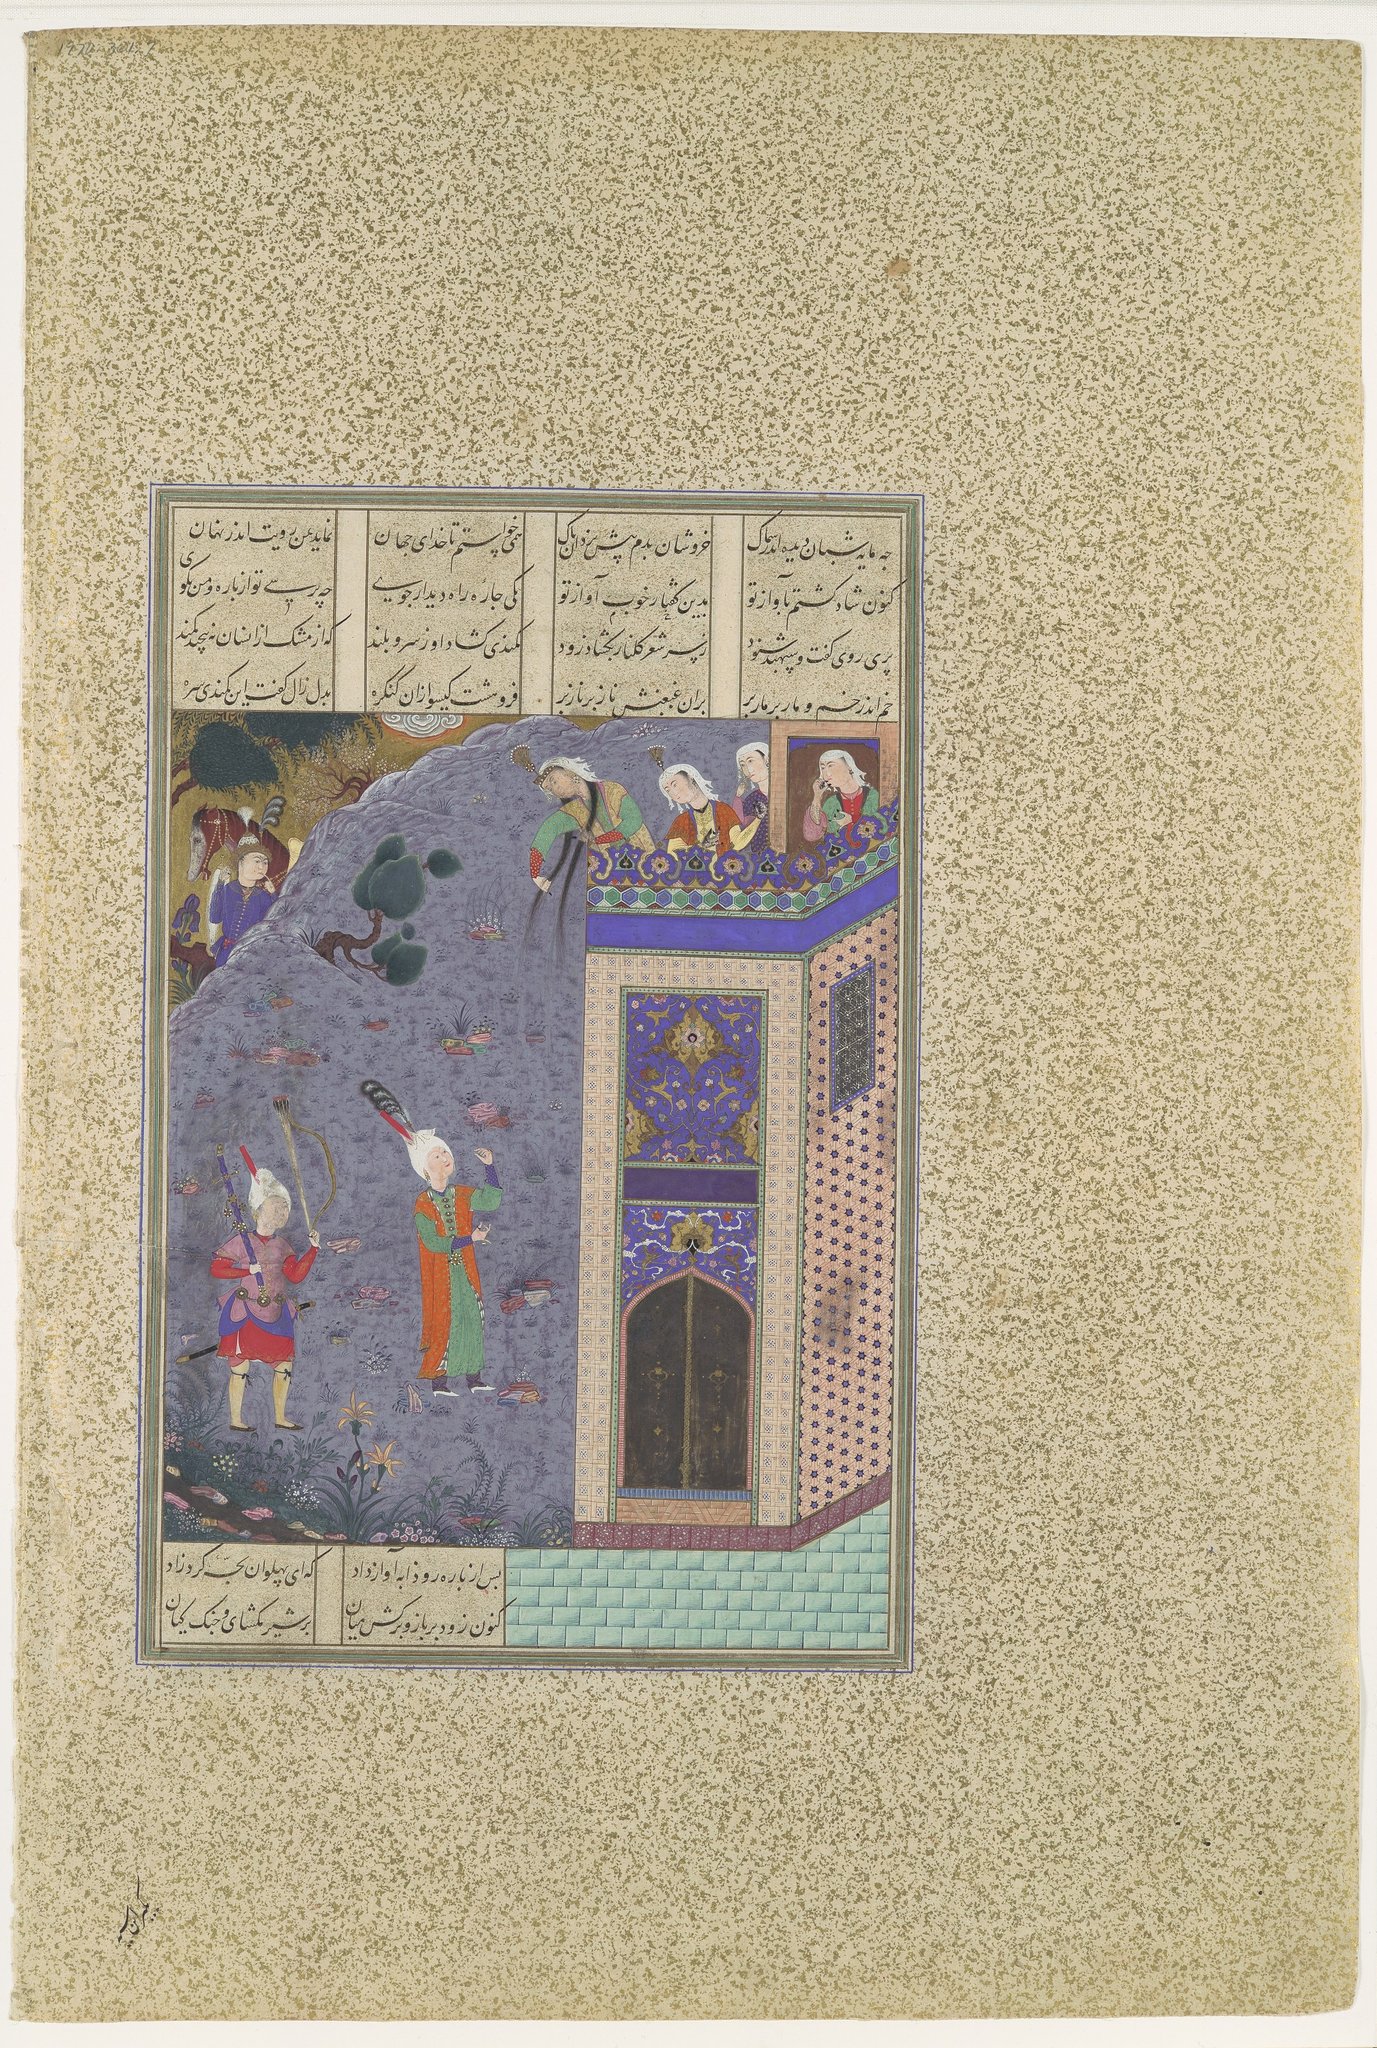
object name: folio from an illustrated manuscript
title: "Rudaba Makes a Ladder of Her Tresses", Folio 72v from the Shahnama (Book of Kings) of Shah Tahmasp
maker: abu'l qasim firdausi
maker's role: author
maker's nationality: iranian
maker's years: 935-1020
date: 1525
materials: gold, ink, paper, silver, watercolor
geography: iran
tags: kings,princesses,women